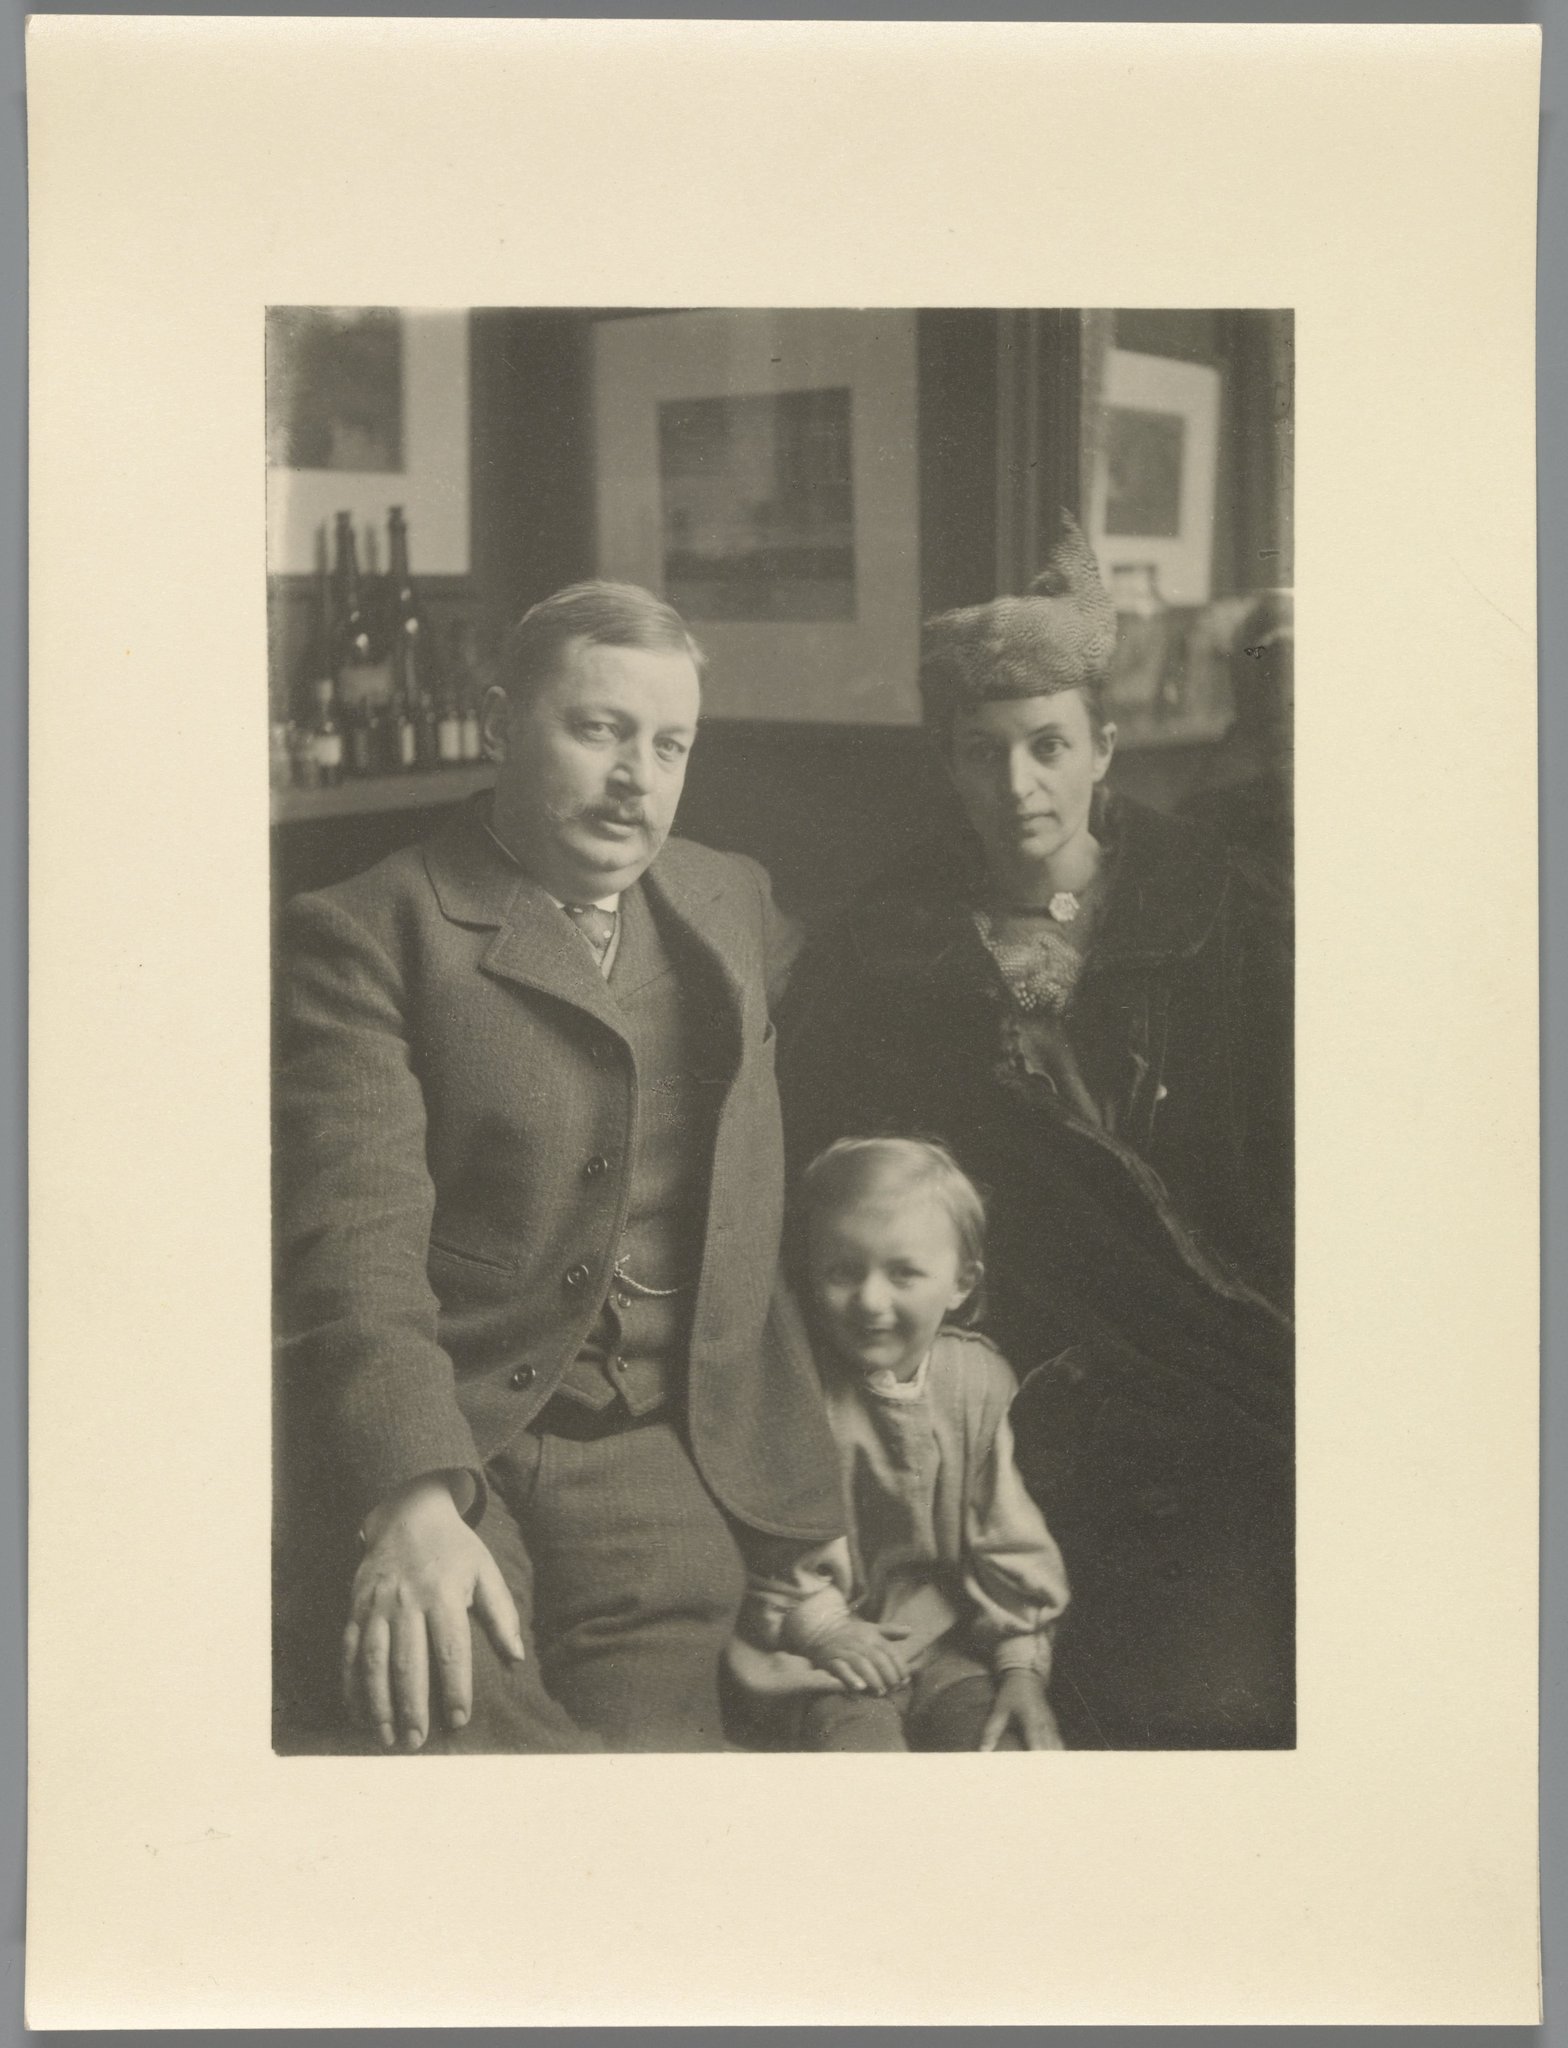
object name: photograph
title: Reproductie naar een foto van Willem Witsen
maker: Anonymous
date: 1860-1915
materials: paper, photographic support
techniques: gelatin silver print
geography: netherlands